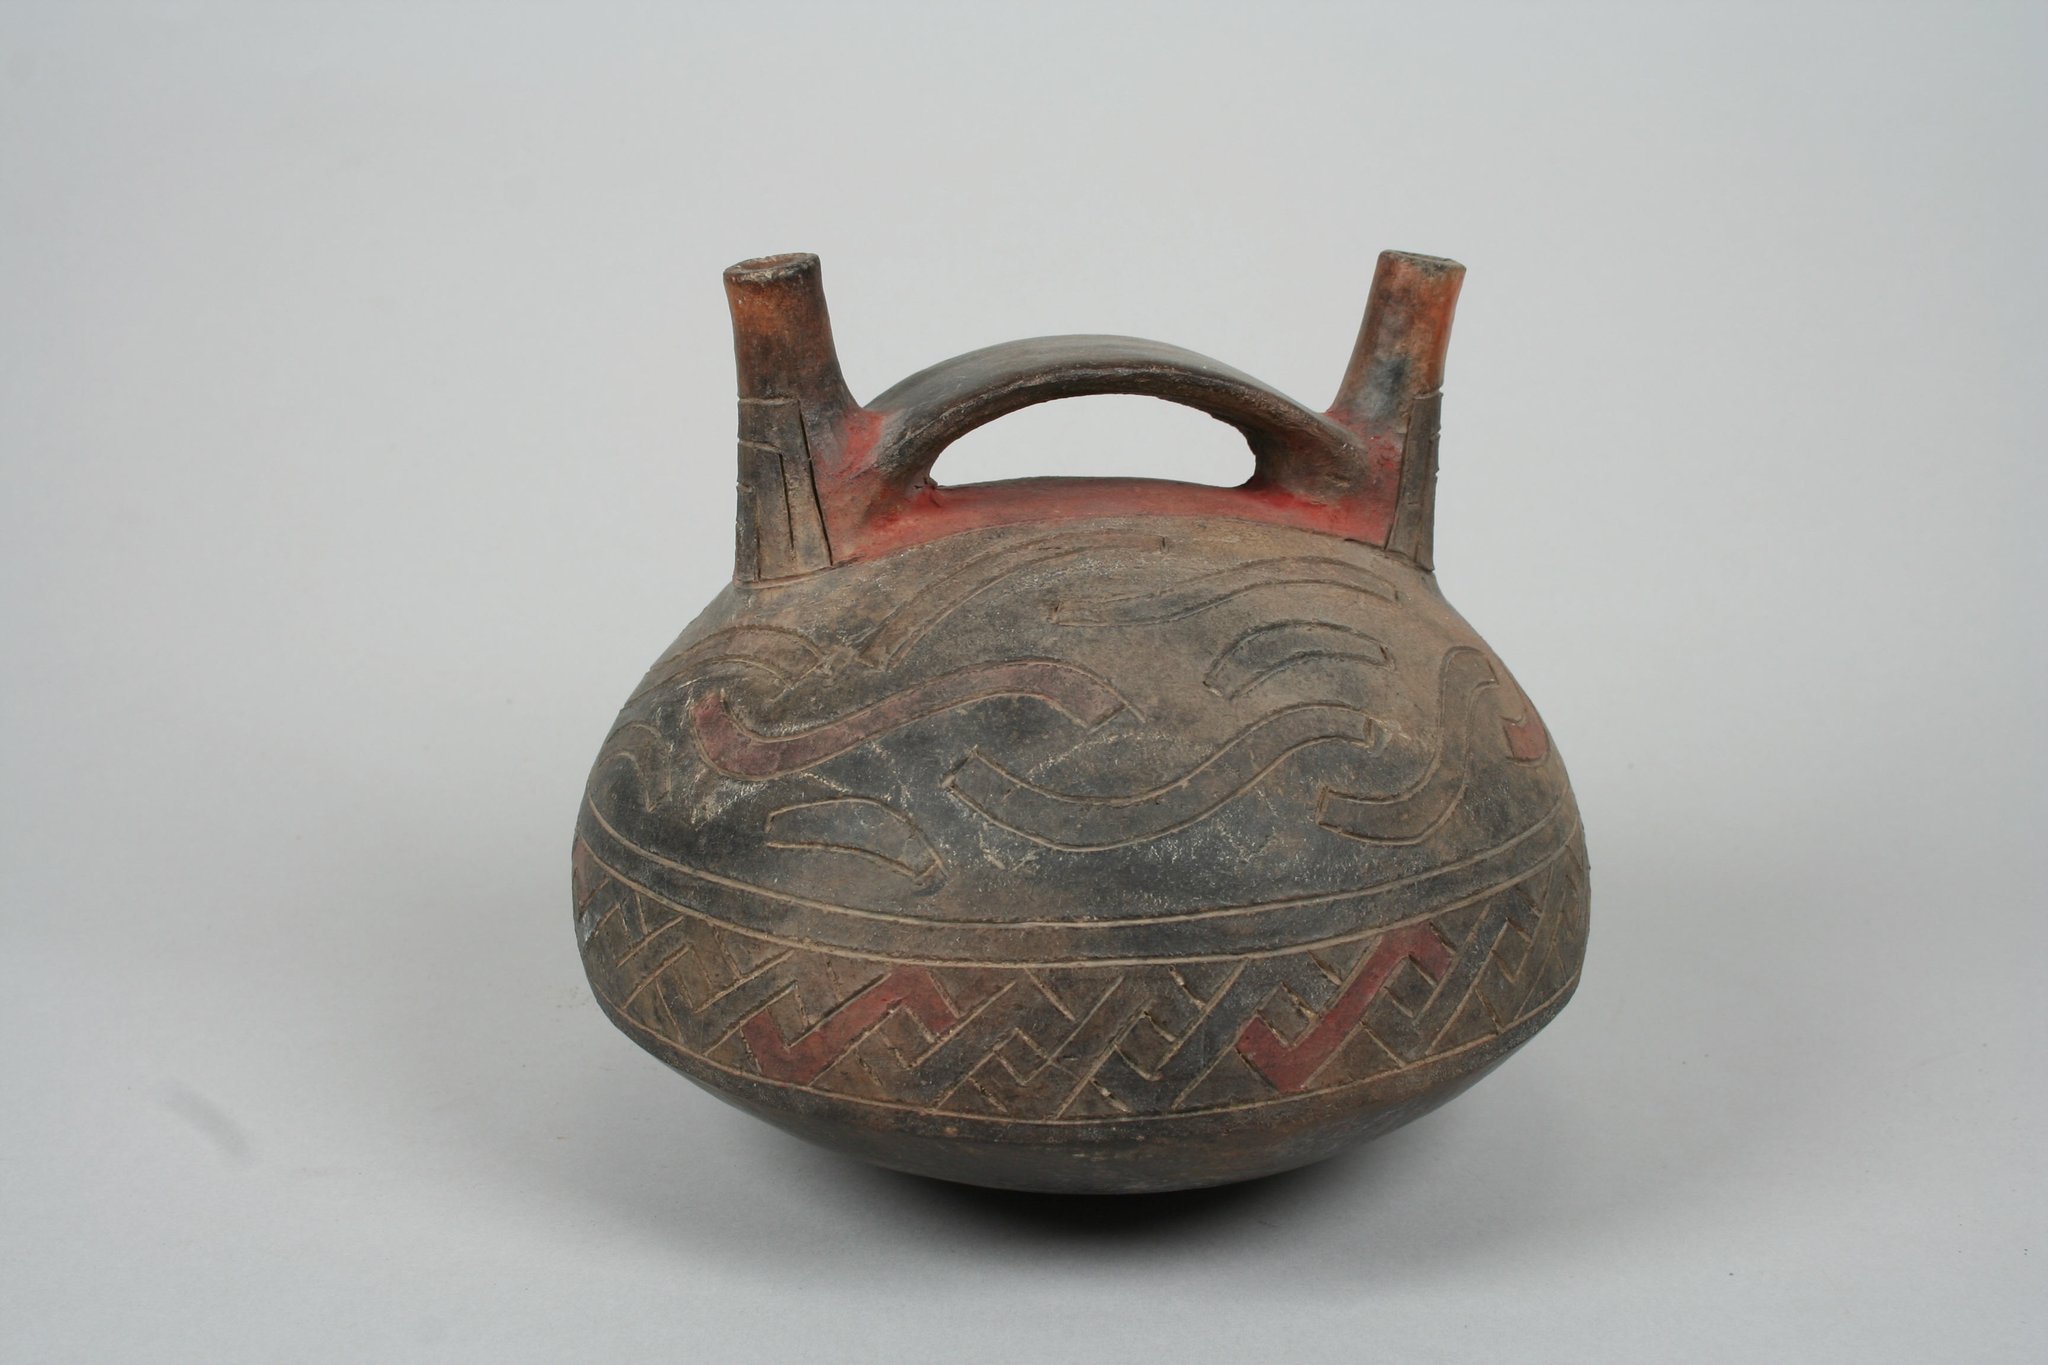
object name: bottle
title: Double Spout and Bridge Bottle with "S" Designs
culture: paracas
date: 700-301 BCE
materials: ceramic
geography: peru